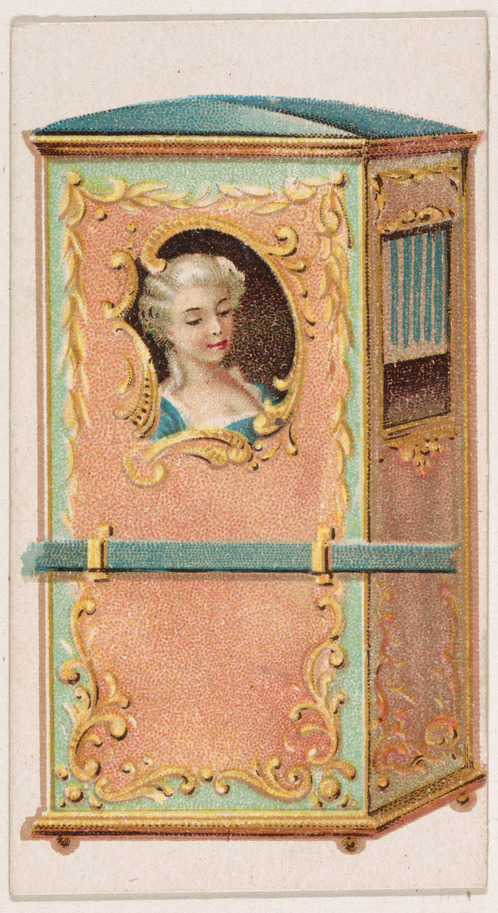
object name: print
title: Palanquin, from the Novelties series (N228, Type 5) issued by Kinney Bros.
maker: kinney brothers tobacco company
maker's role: publisher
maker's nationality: american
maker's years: 1869-2011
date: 1889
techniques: color lithograph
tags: women,transportation